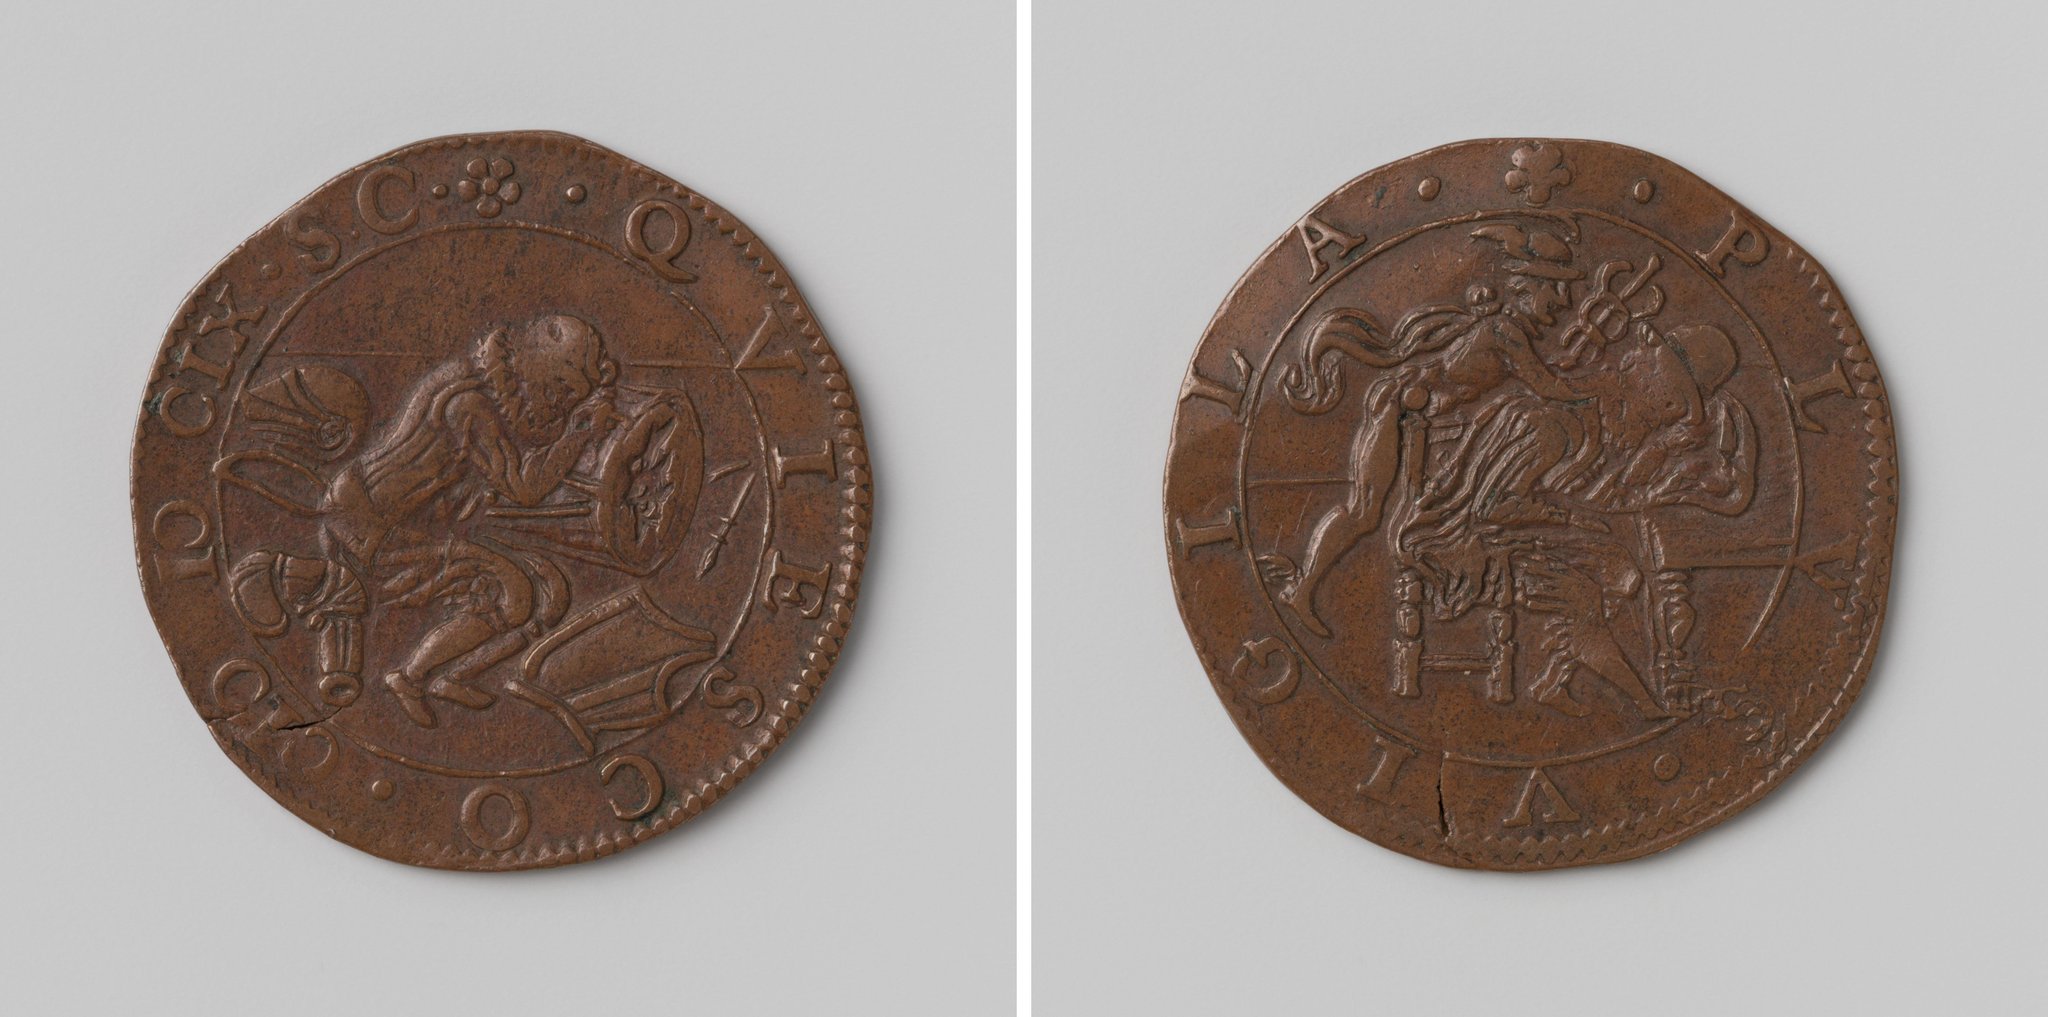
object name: jeton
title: Sluiting van het Twaalfjarig Bestand tussen de Republiek en Spanje en aansporing tot waakzaamheid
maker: Anonymous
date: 1609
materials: copper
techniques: striking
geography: dordrecht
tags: staten-generaal, twaalfjarig bestand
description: Koperen penning. Voorzijde: zittend temidden van afgelegd wapentuig rust een soldaat op een gescheurde trommel binnen omschrift. Keerzijde: Mercurius met staf in handen trekt man, die aan tafel ligt te slapen, aan zijn oor binnen omschrift